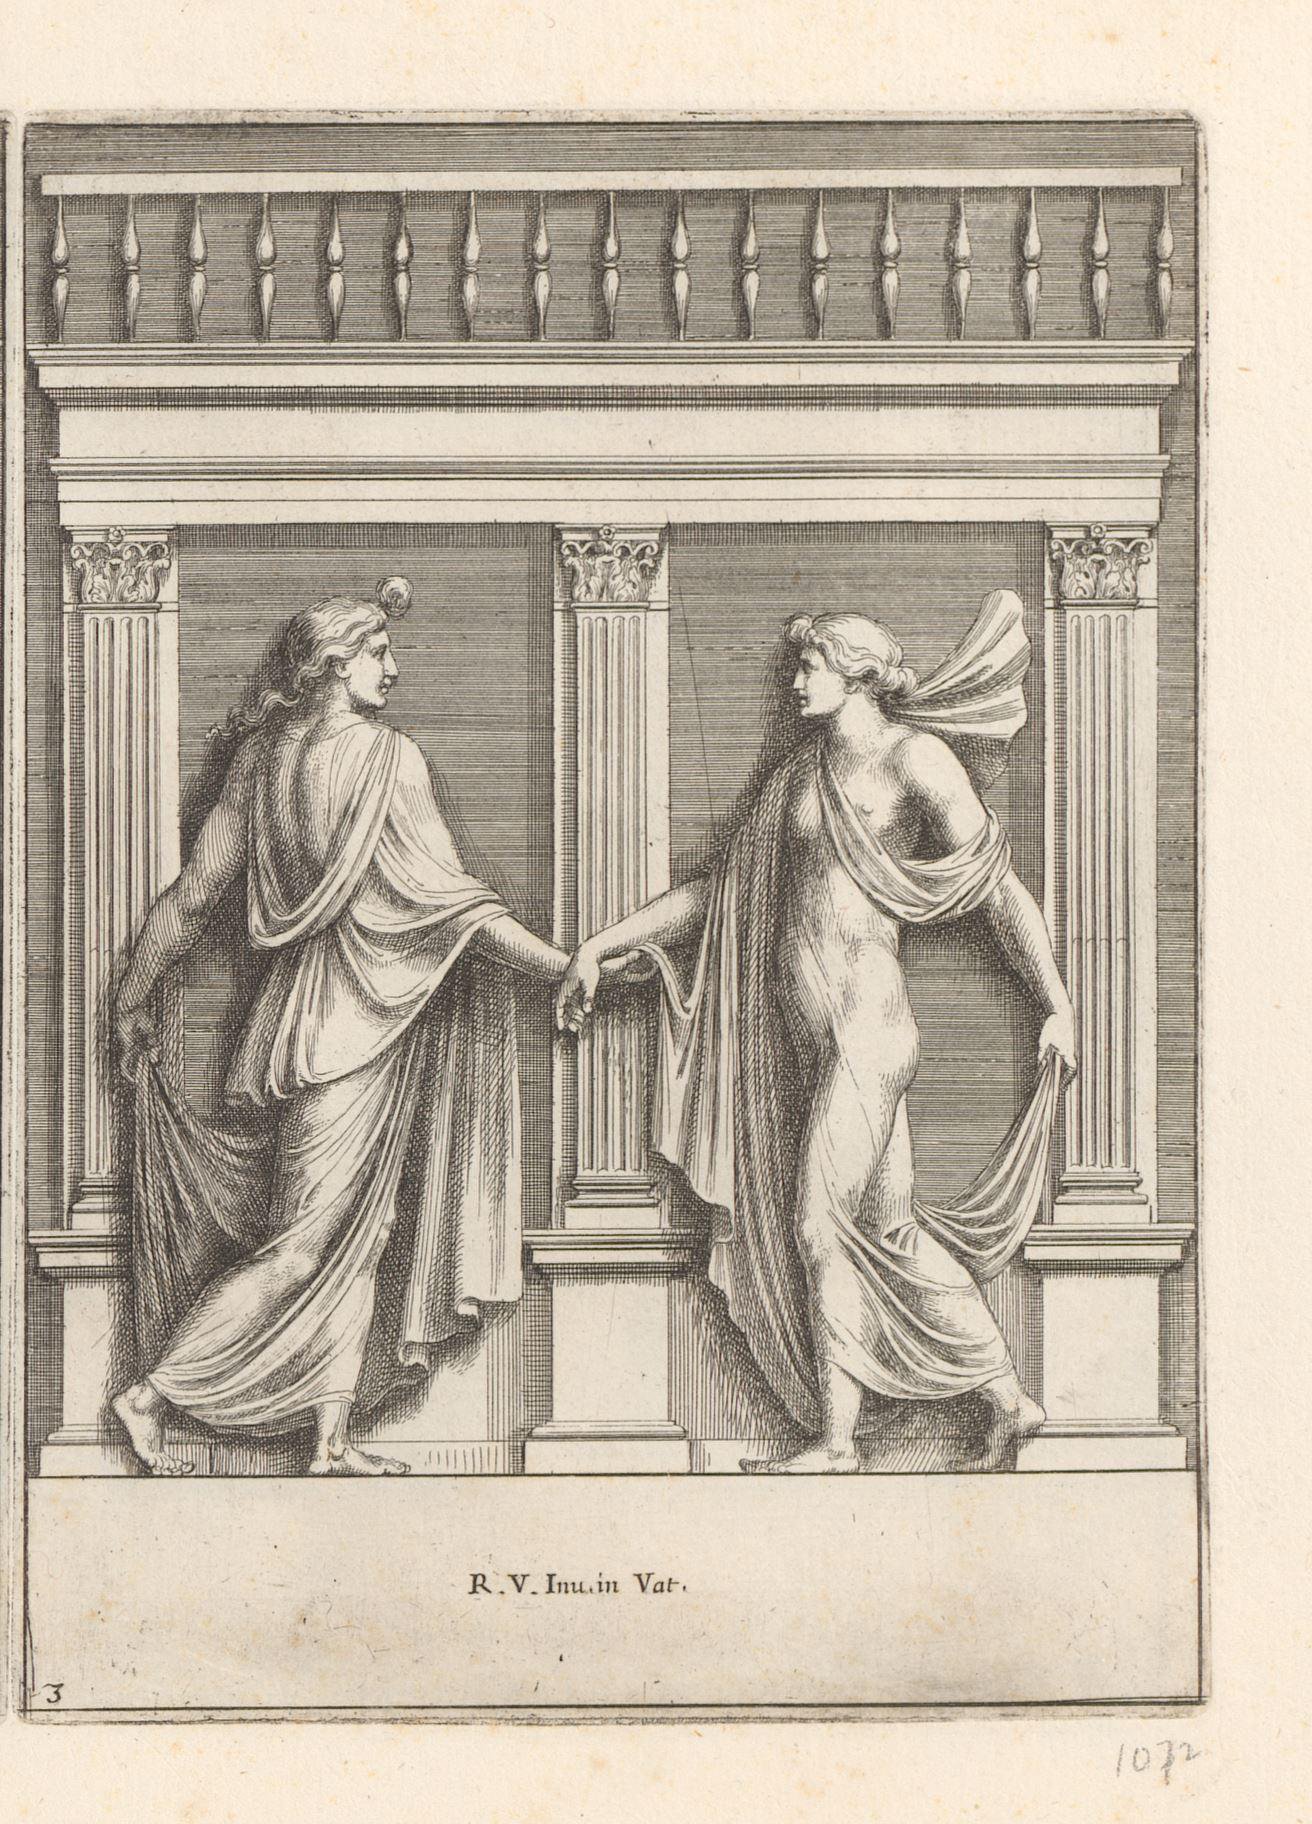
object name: print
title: Reliëfs in de Loggia van Rafaël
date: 1645-1700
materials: paper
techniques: engraving, etching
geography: italy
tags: adult woman, dancing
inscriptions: number: ‘37’, inscription: ‘Ende lib. No. 7. fol. 37. 38. 46. 47. lin. 12. fol. 36. 37. 38. 39. 40 et 43.’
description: Prent uit een reeks naar de gipsen reliëfs door Rafaël en uitgevoerd door zijn assistenten in de Vaticaanse Loggia.